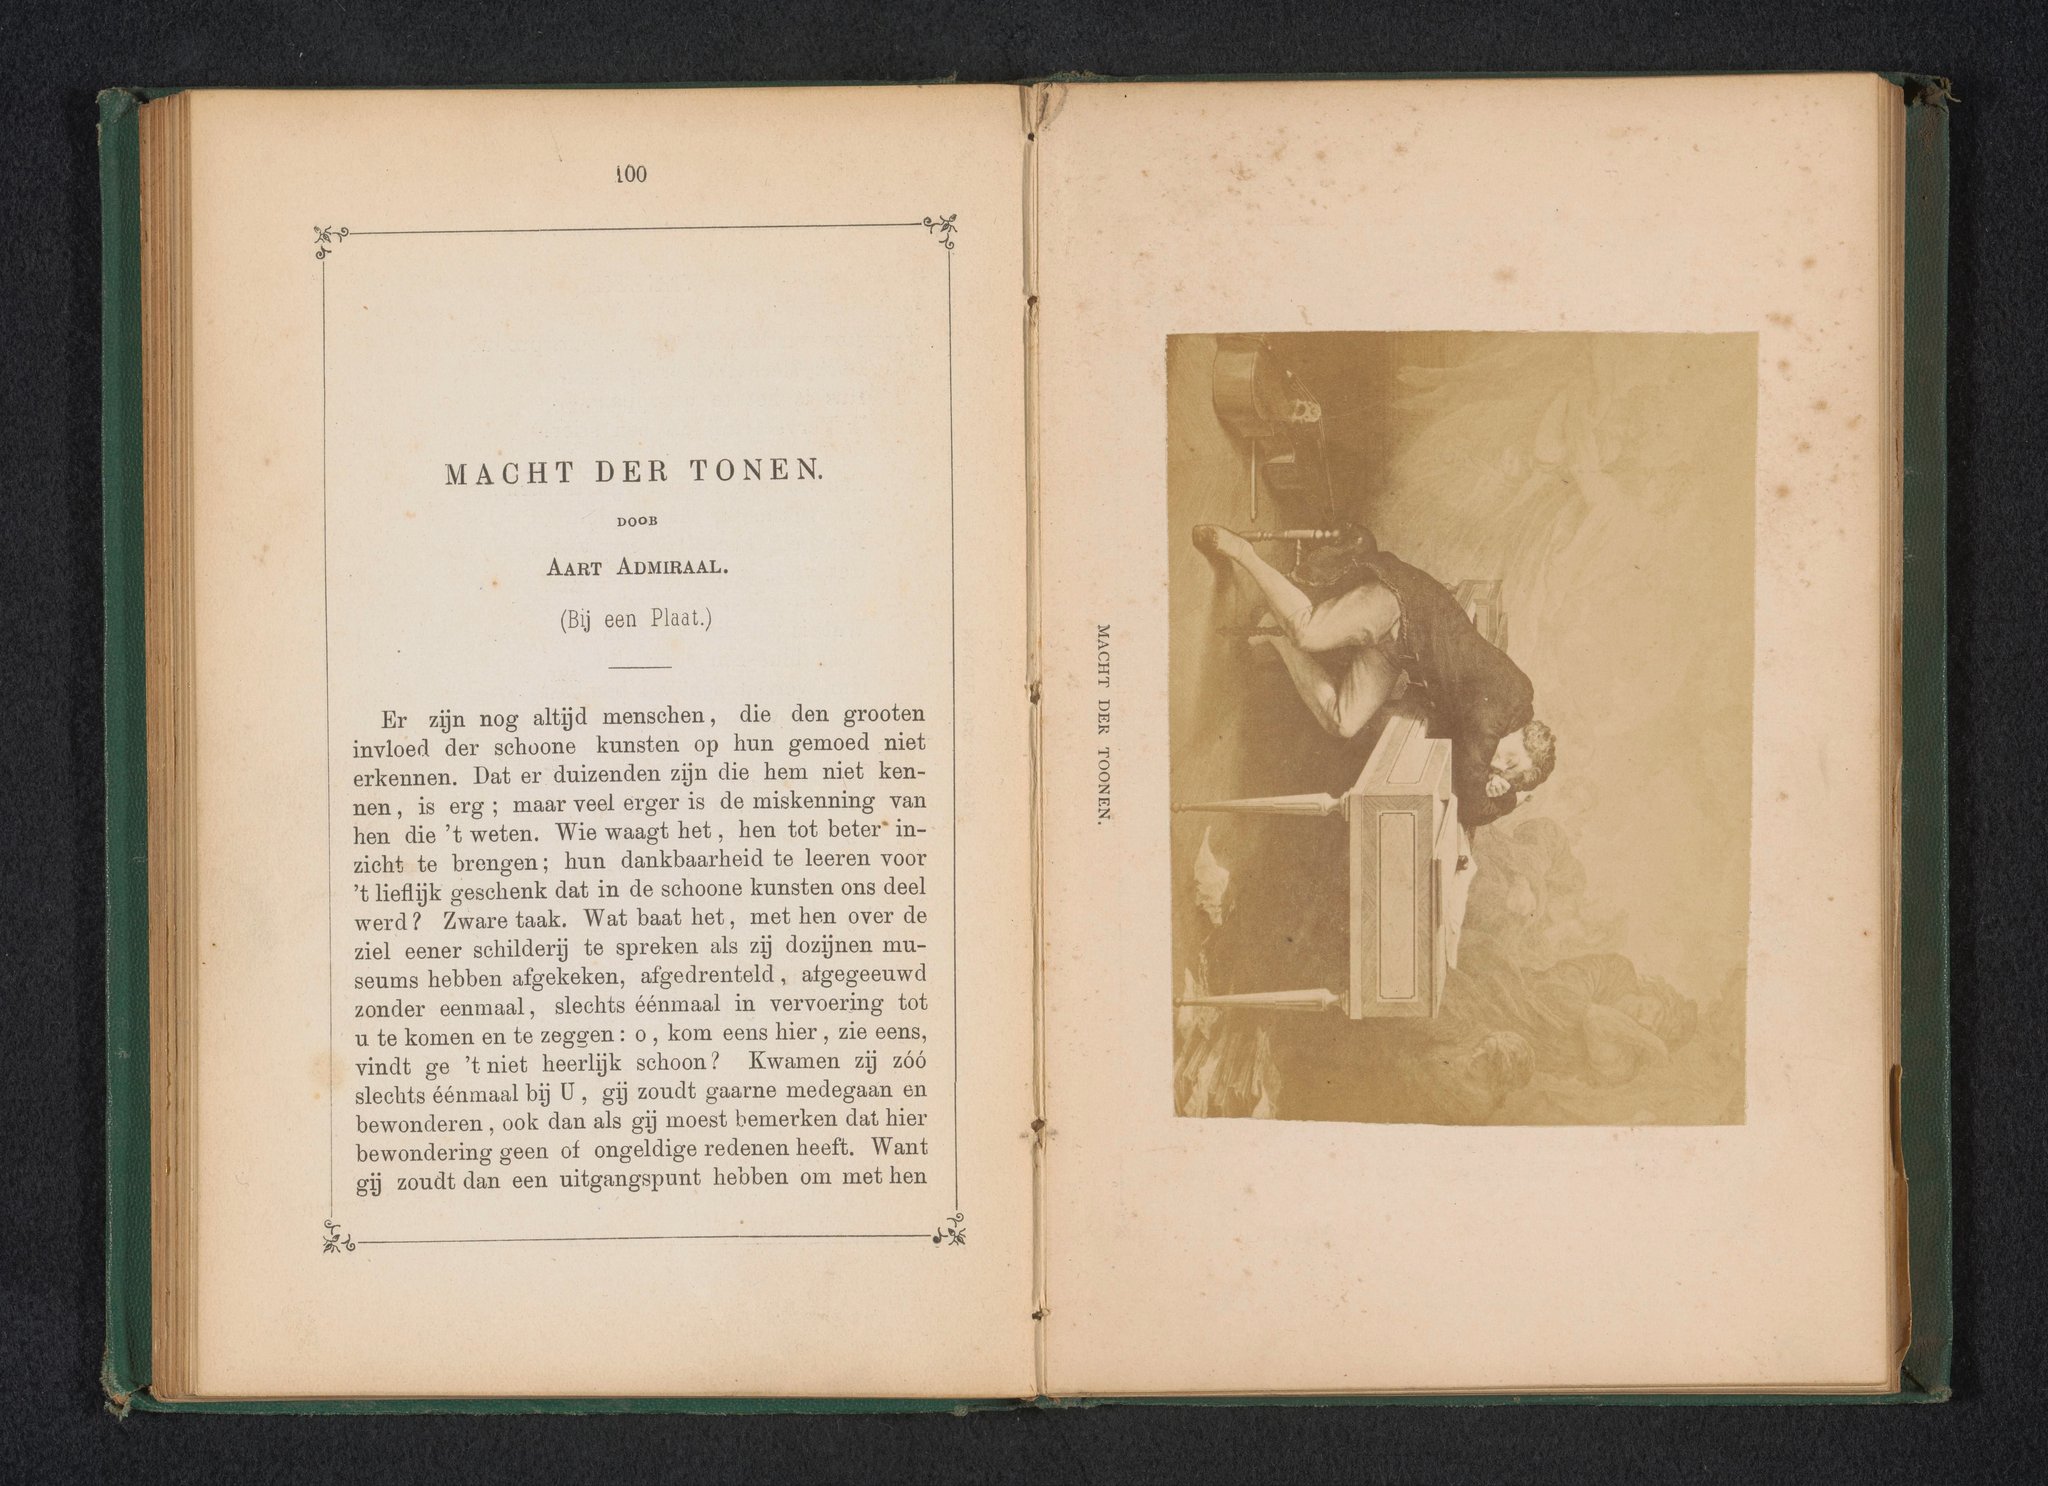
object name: photograph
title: Fotoreproductie van een schilderij van een man die voorover ligt op een bureau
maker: Anonymous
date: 1871-1876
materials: photographic support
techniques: albumen print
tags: writing-table, writing-desk, adult man